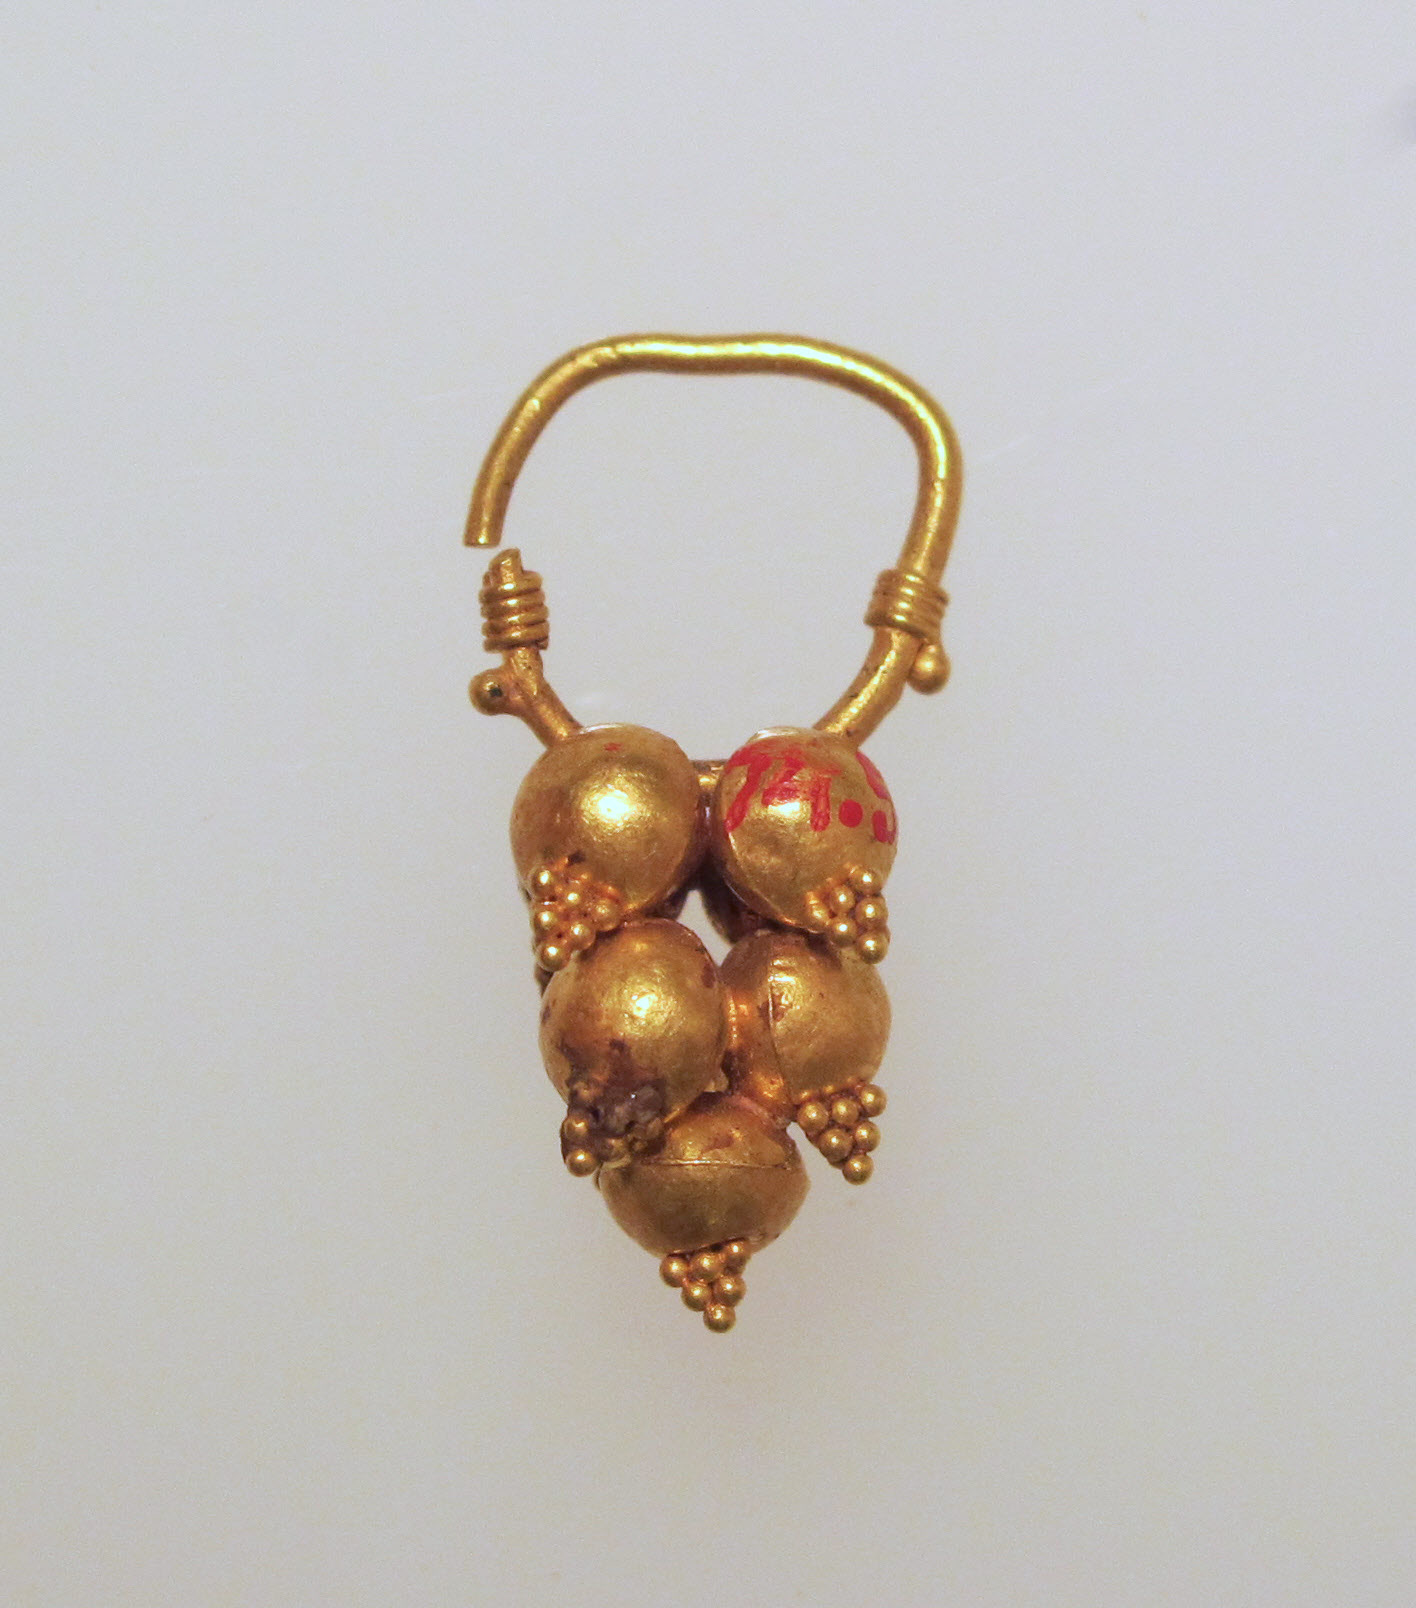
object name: earring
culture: roman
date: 101-300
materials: gold